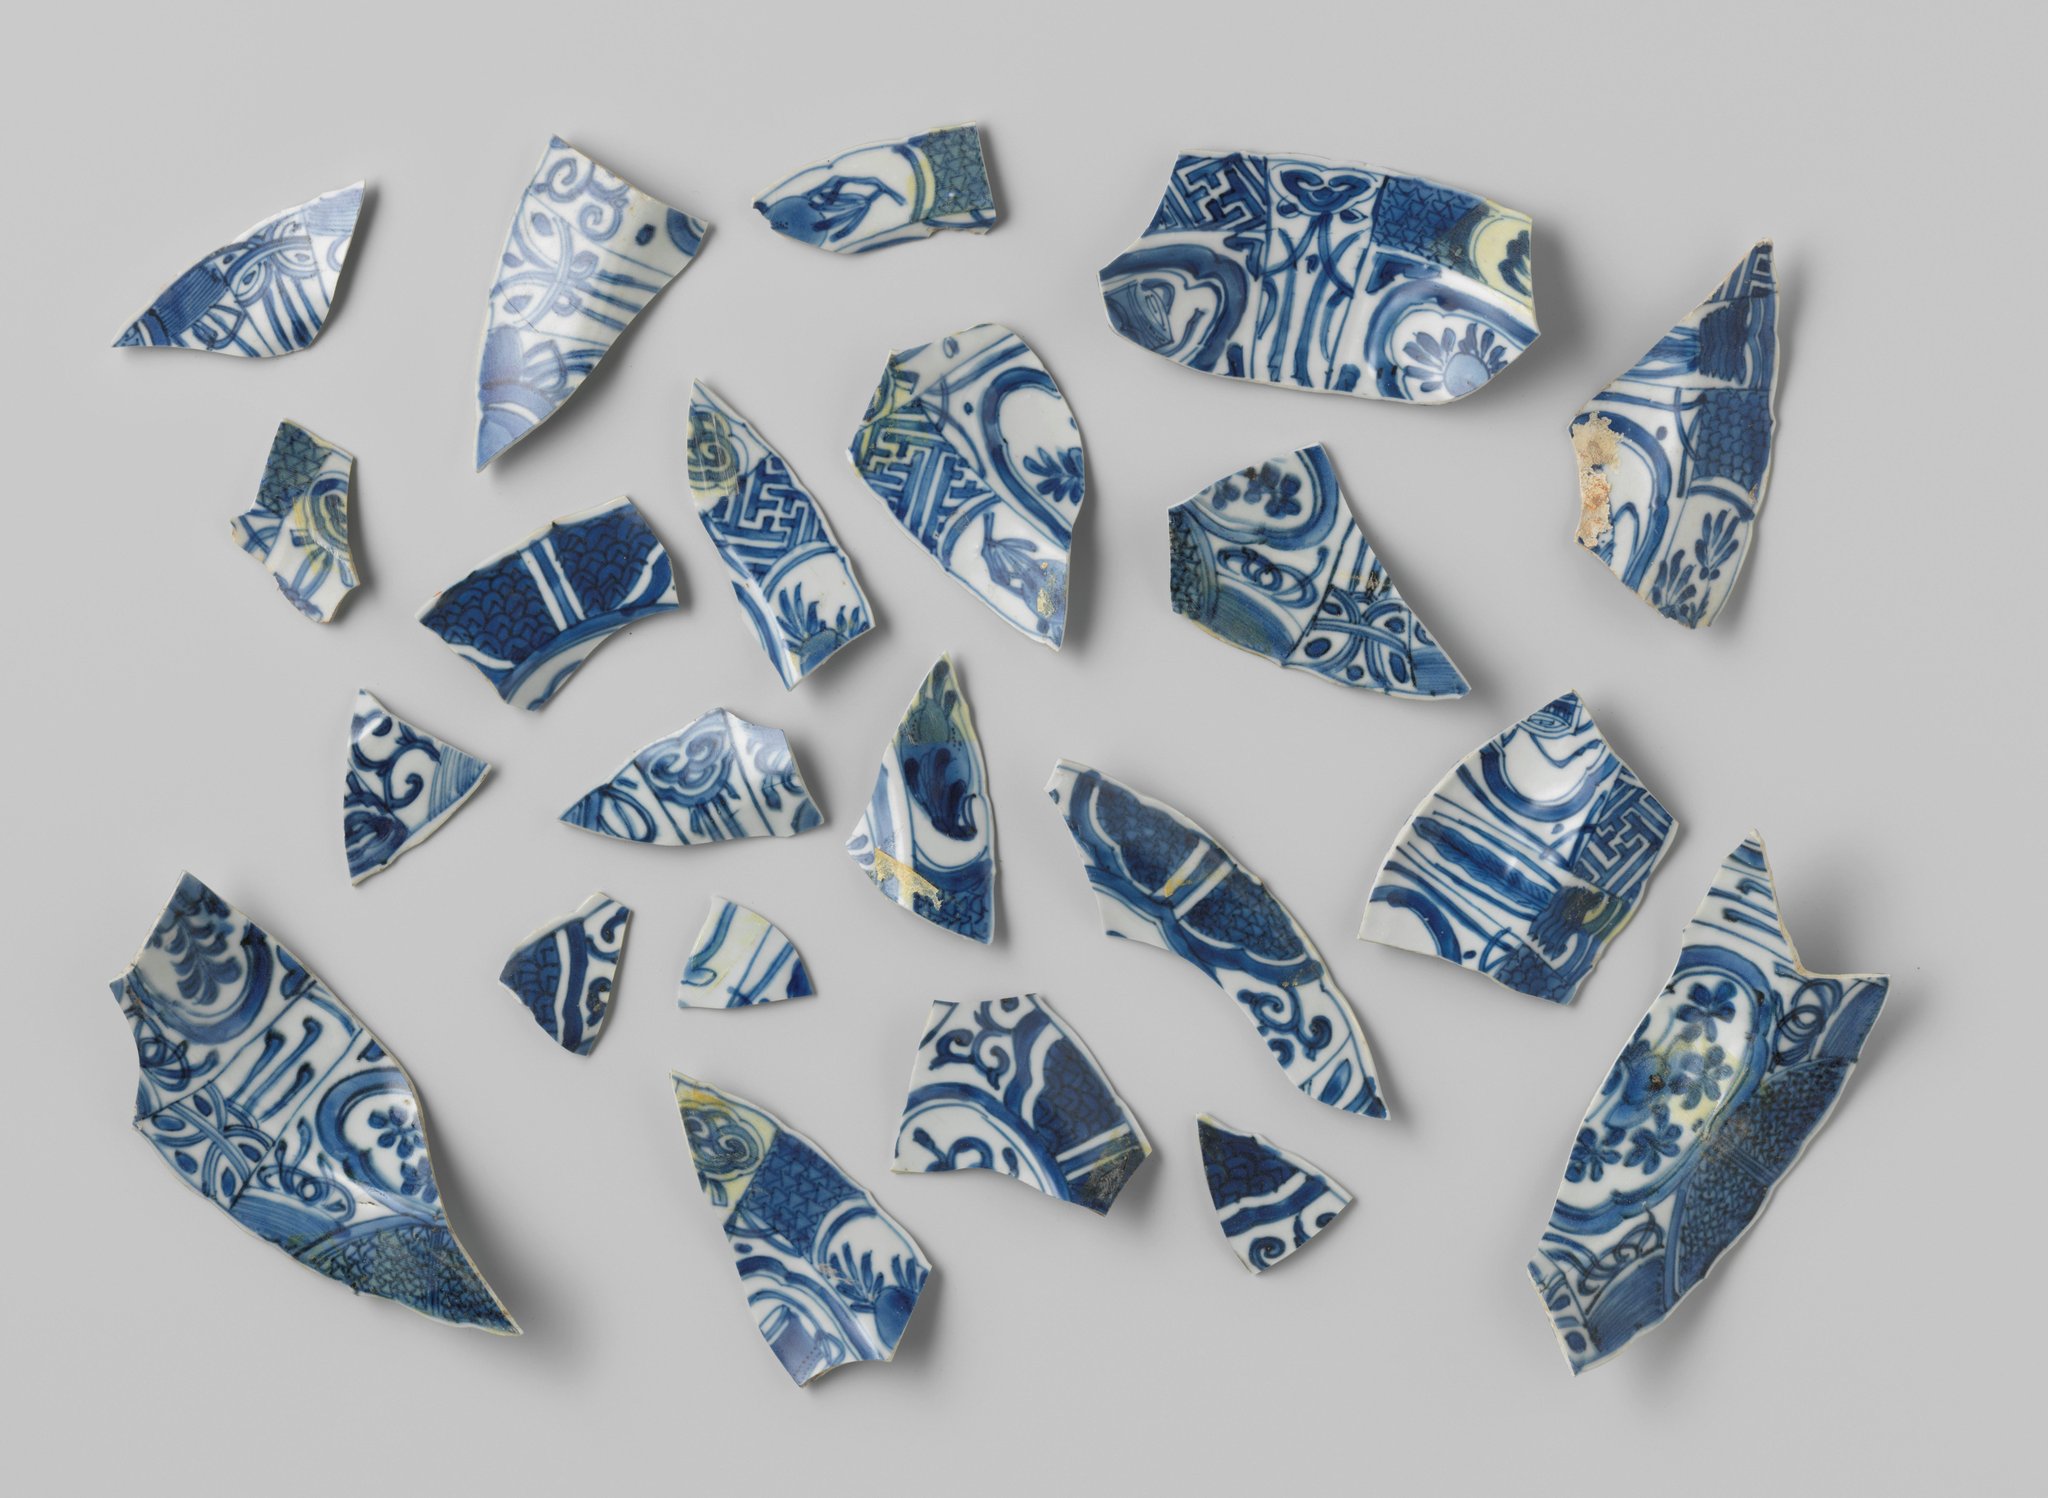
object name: sherd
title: Scherven kraakporselein uit V.O.C.-schip de 'Witte Leeuw'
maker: Anonymous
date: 1613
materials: bone china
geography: jingdezhen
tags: verenigde oostindische compagnie, sint-helena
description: Scherven kraakporselein uit V.O.C.-schip de 'Witte Leeuw'.